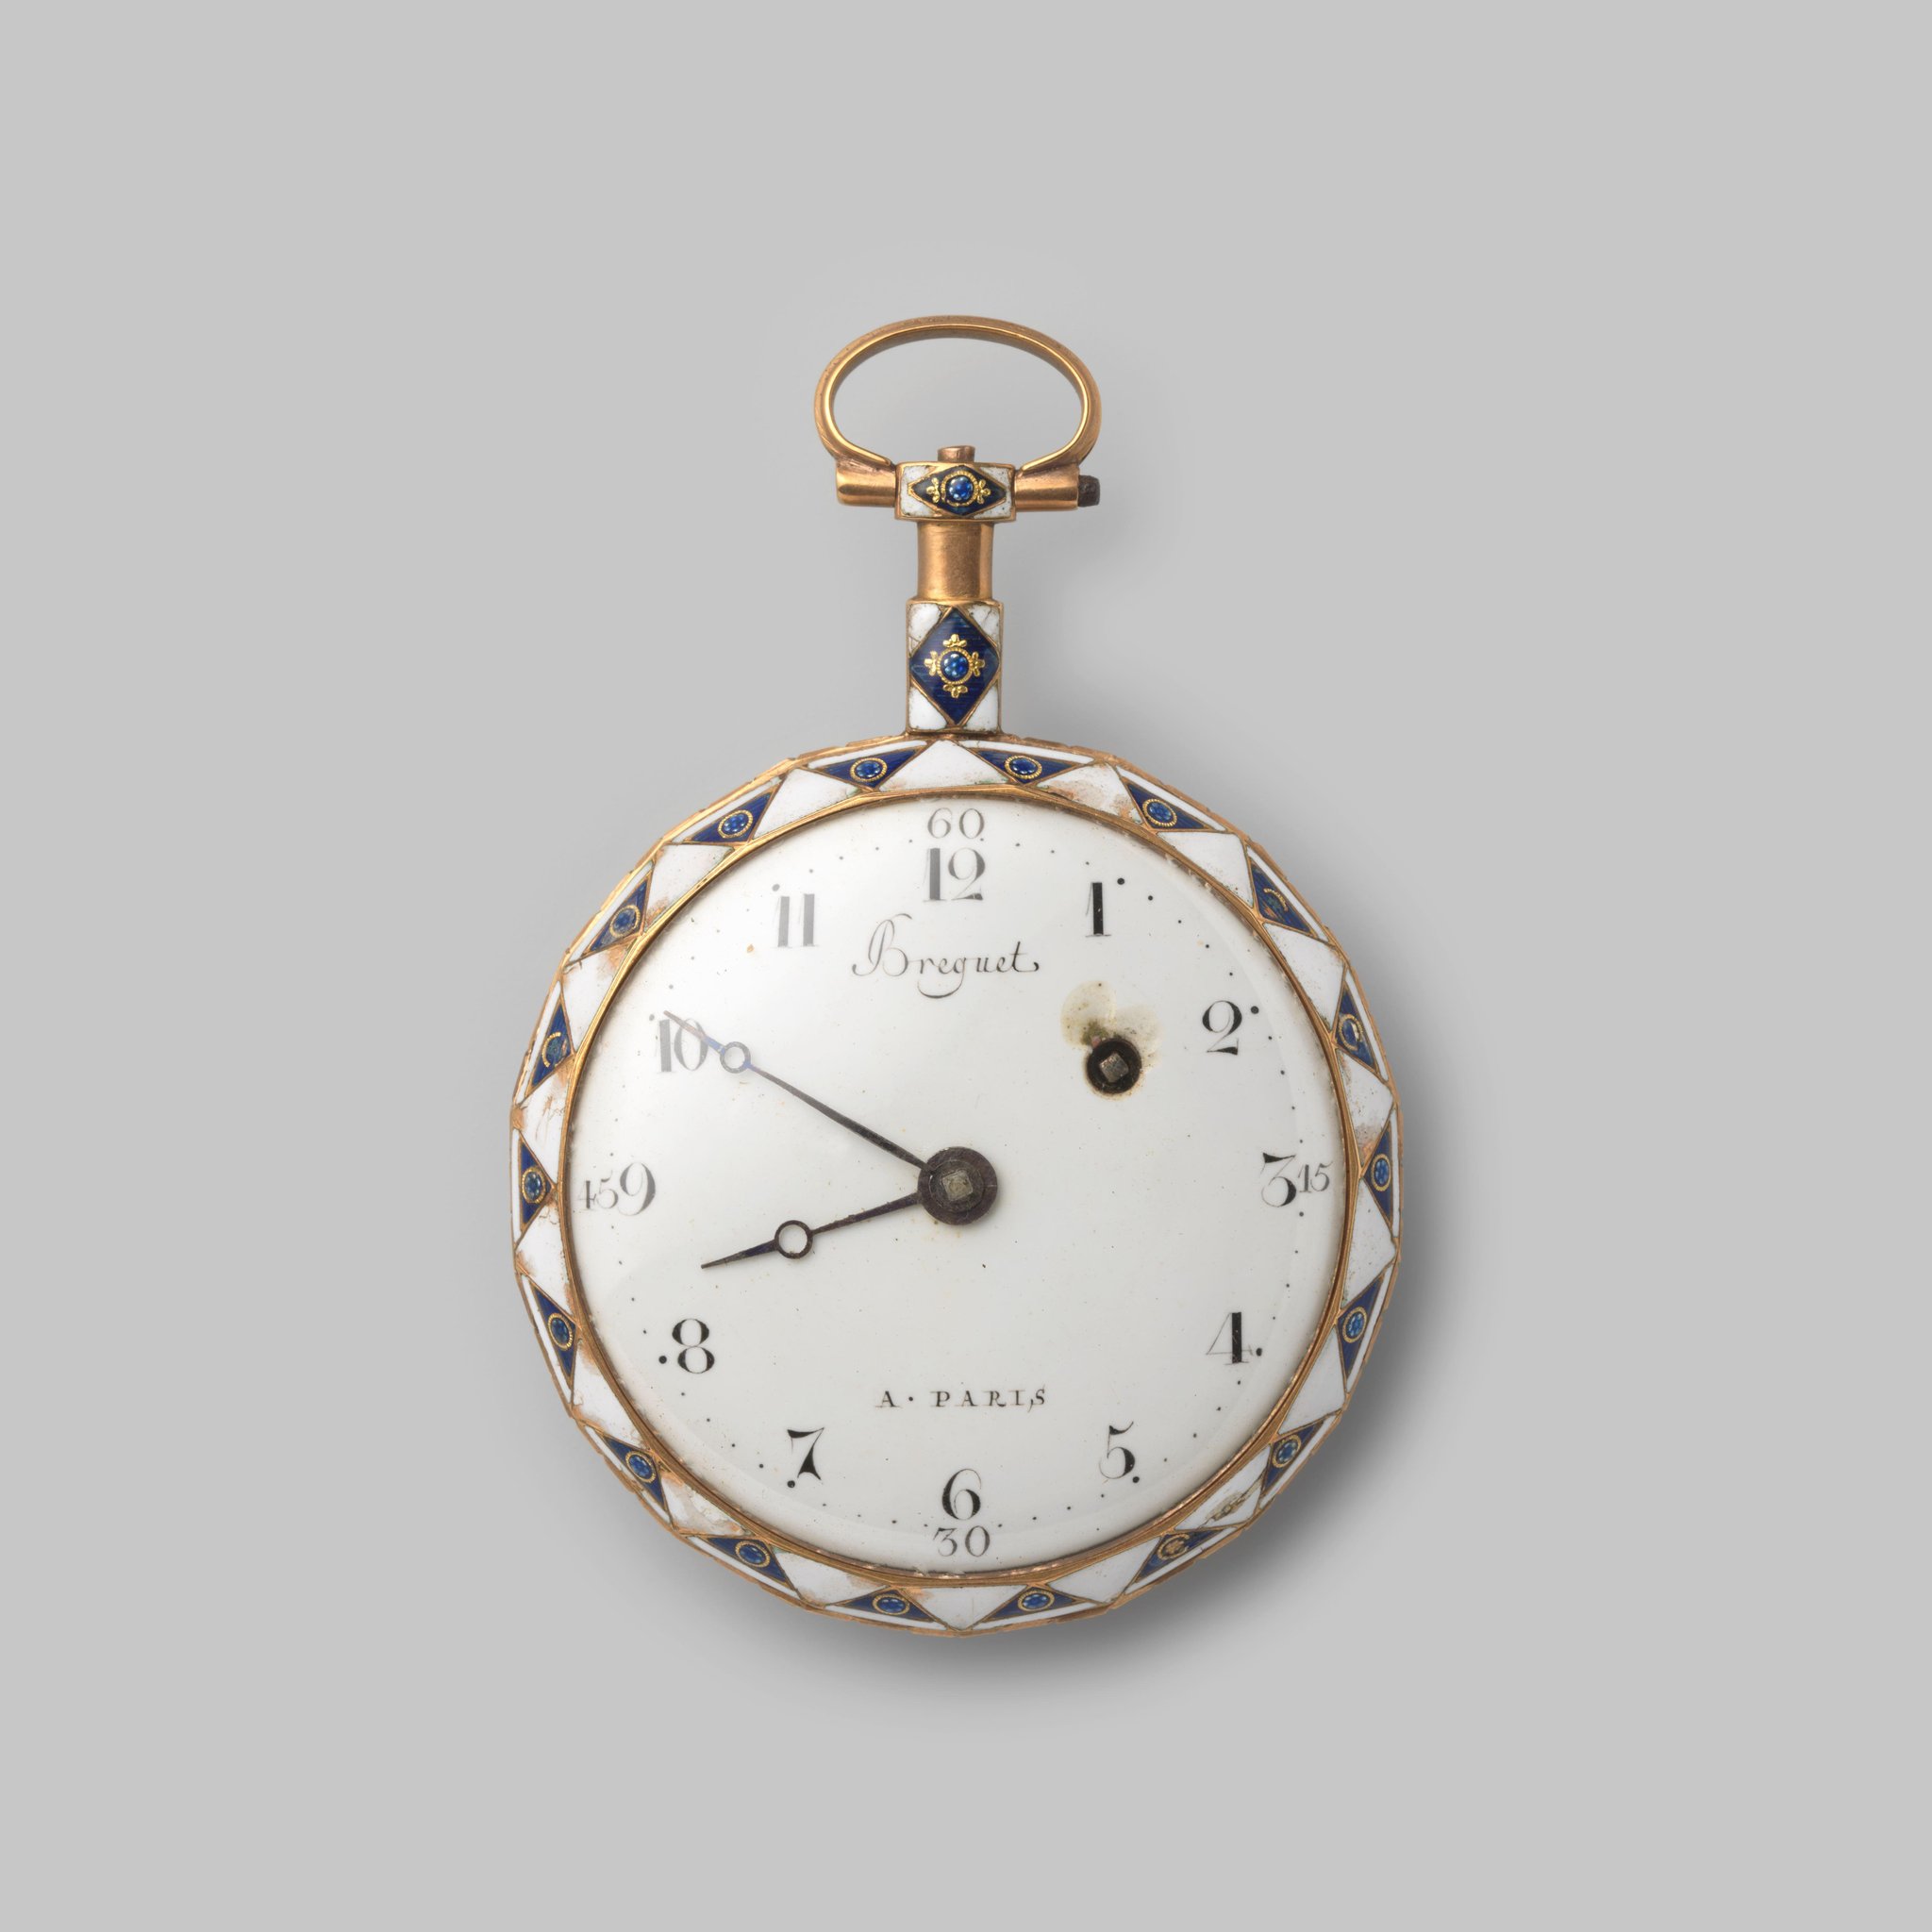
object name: jewellery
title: Horloge van goud met translucide email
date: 1795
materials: diamond, gold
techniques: enameling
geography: paris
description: Gouden horloge met blauw translucide email, waarop een rozet met diamantjes.